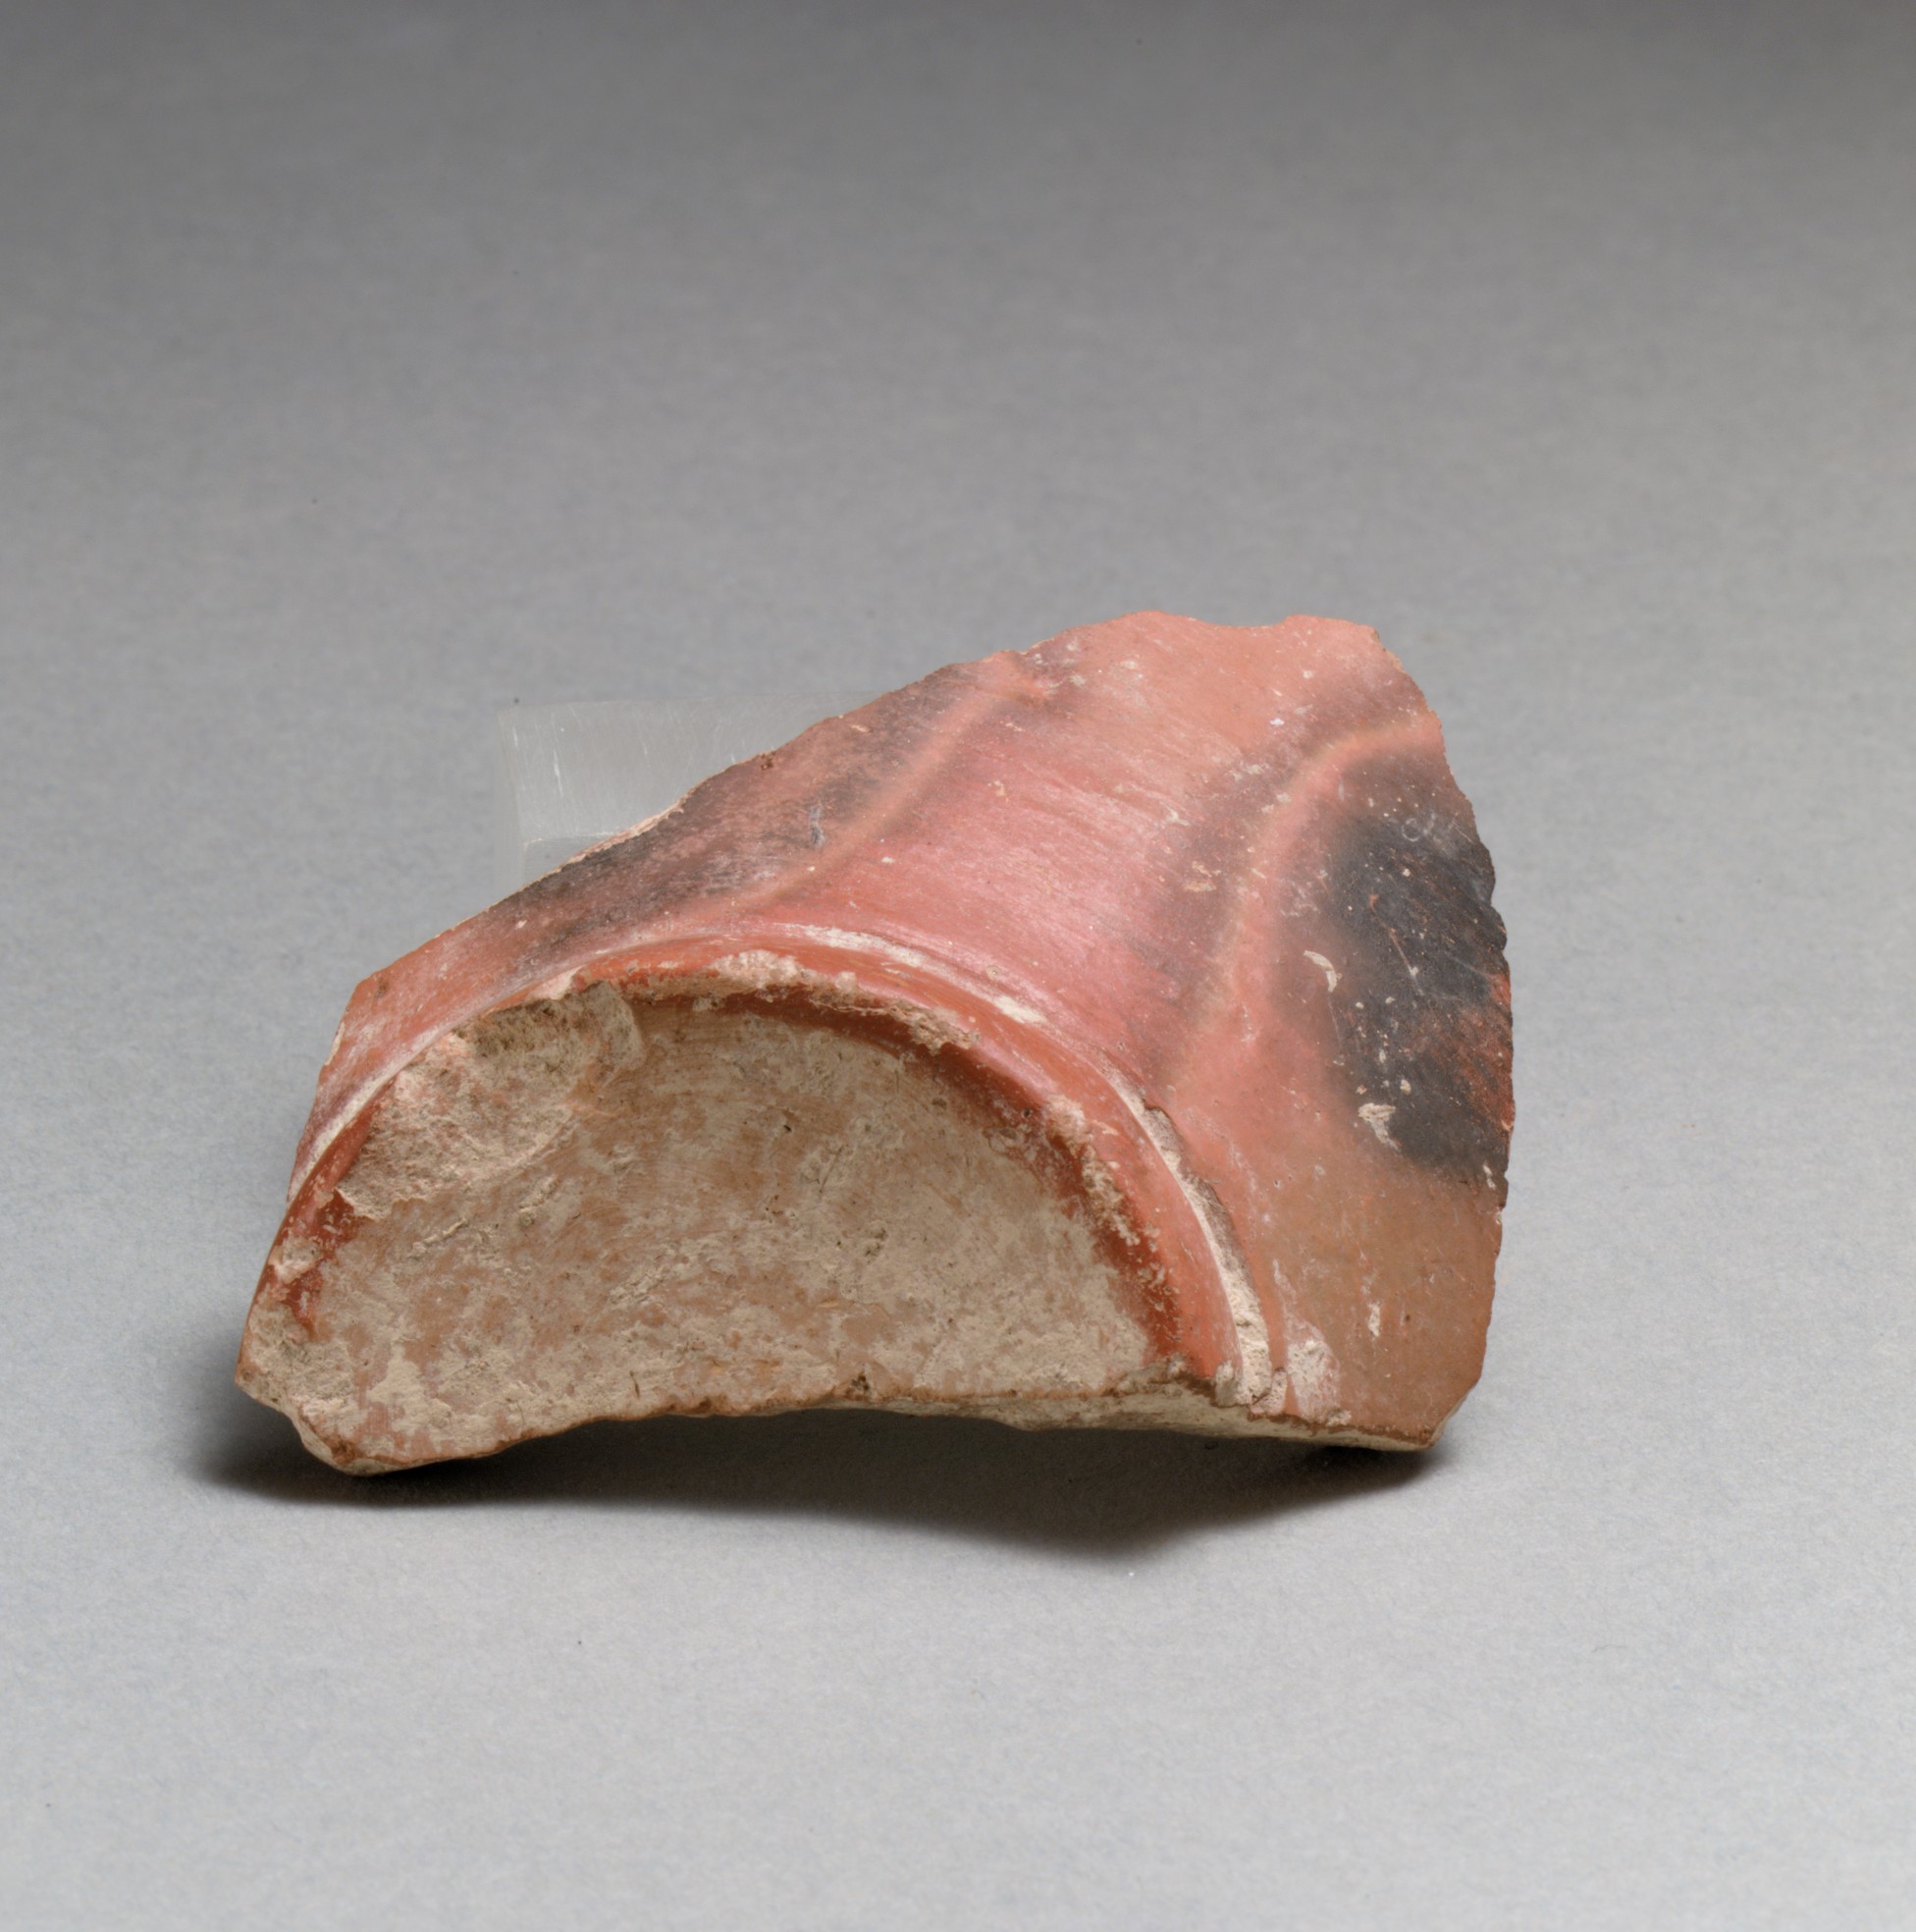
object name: cup, fragment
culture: minoan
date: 2600-2000 BCE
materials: terracotta